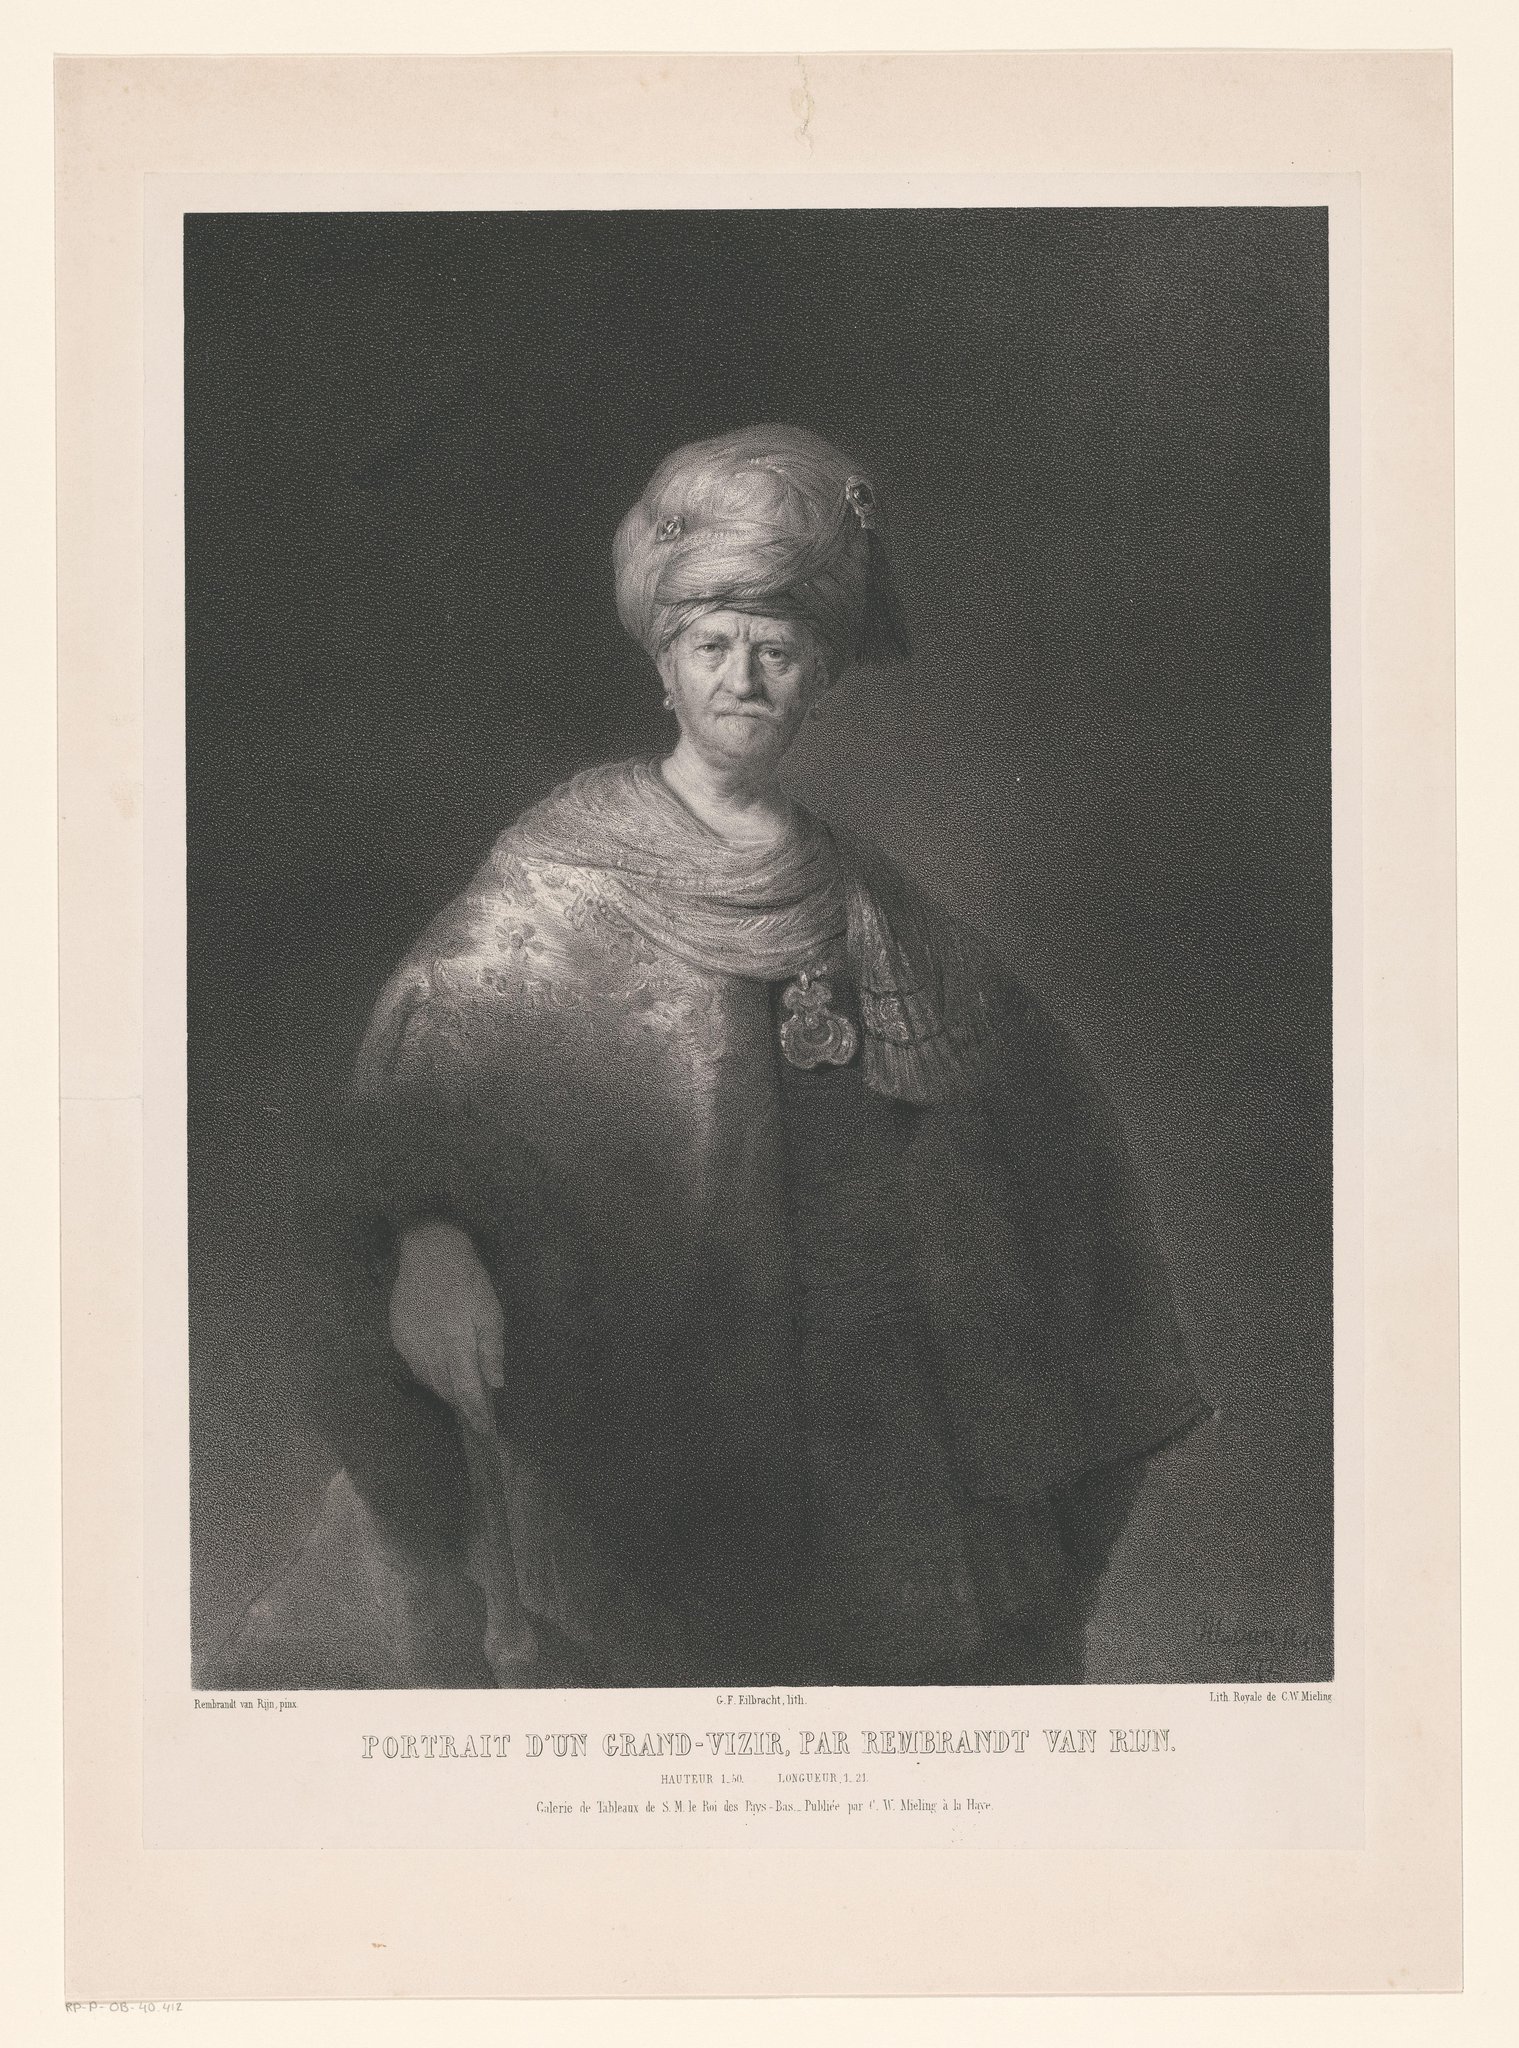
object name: print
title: Portrait d'un grand-vizir, par Rembrandt van Rijn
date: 1847-1854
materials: paper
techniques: lithograph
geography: the hague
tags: old man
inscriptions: collector's mark: Lugt 2228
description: Naar Man in oriëntaalse kleding (1632) van Rembrandt Harmensz. van Rijn in de collectie van het Metropolitan Museum of Art te New York.